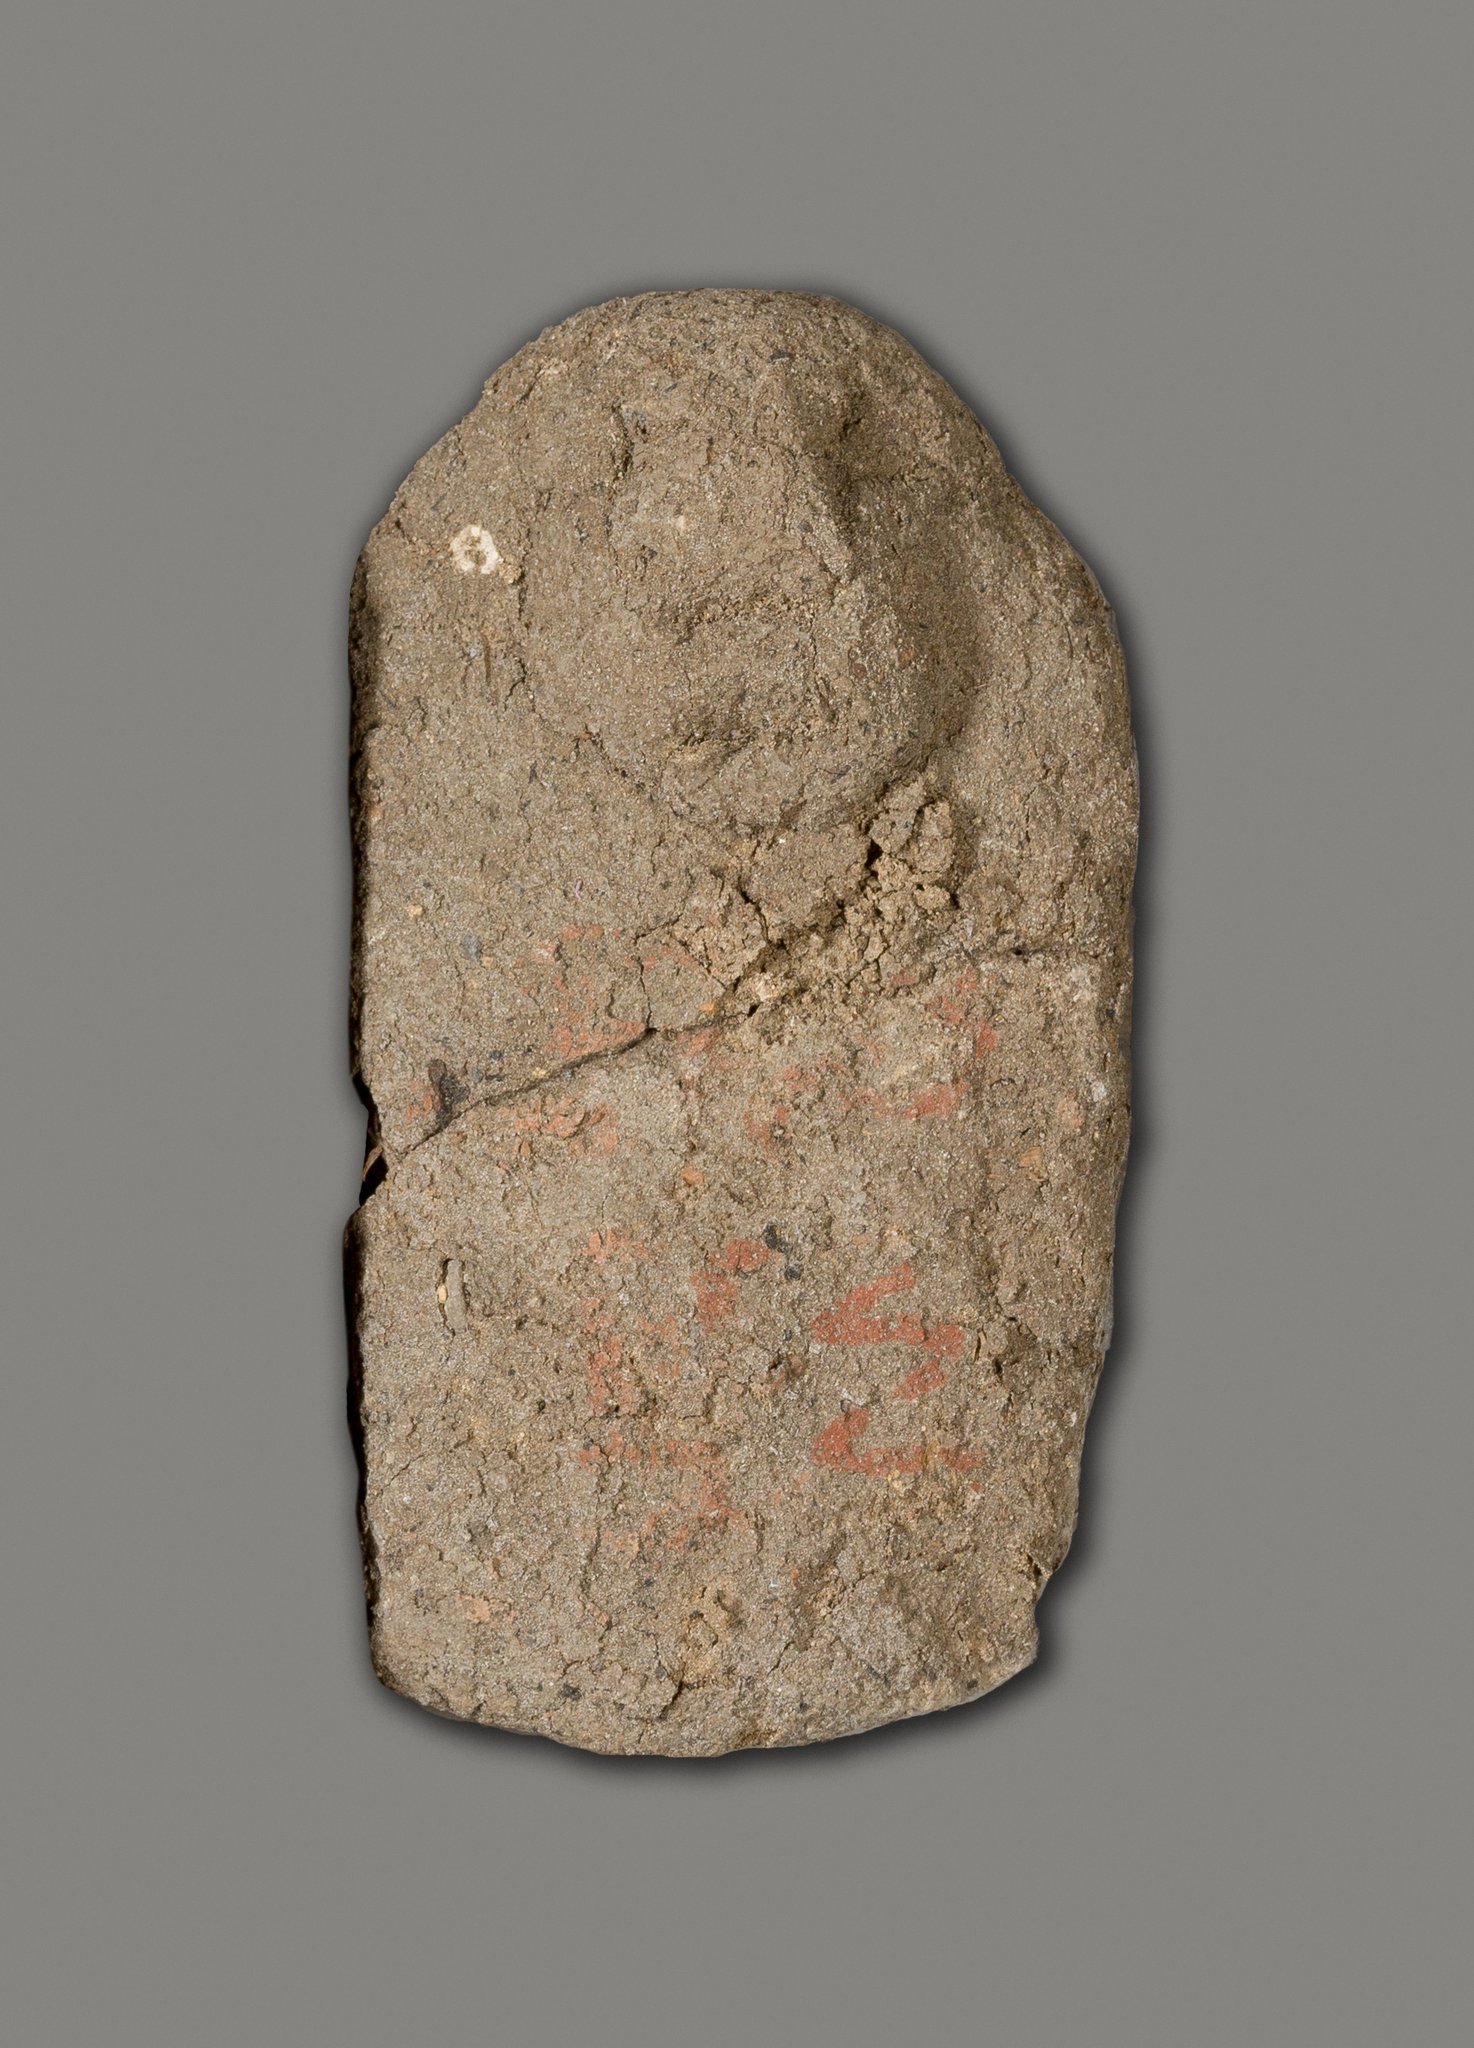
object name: figure, magical, execration, tablet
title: Magical Figure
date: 1802-1550 BCE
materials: clay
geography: egypt